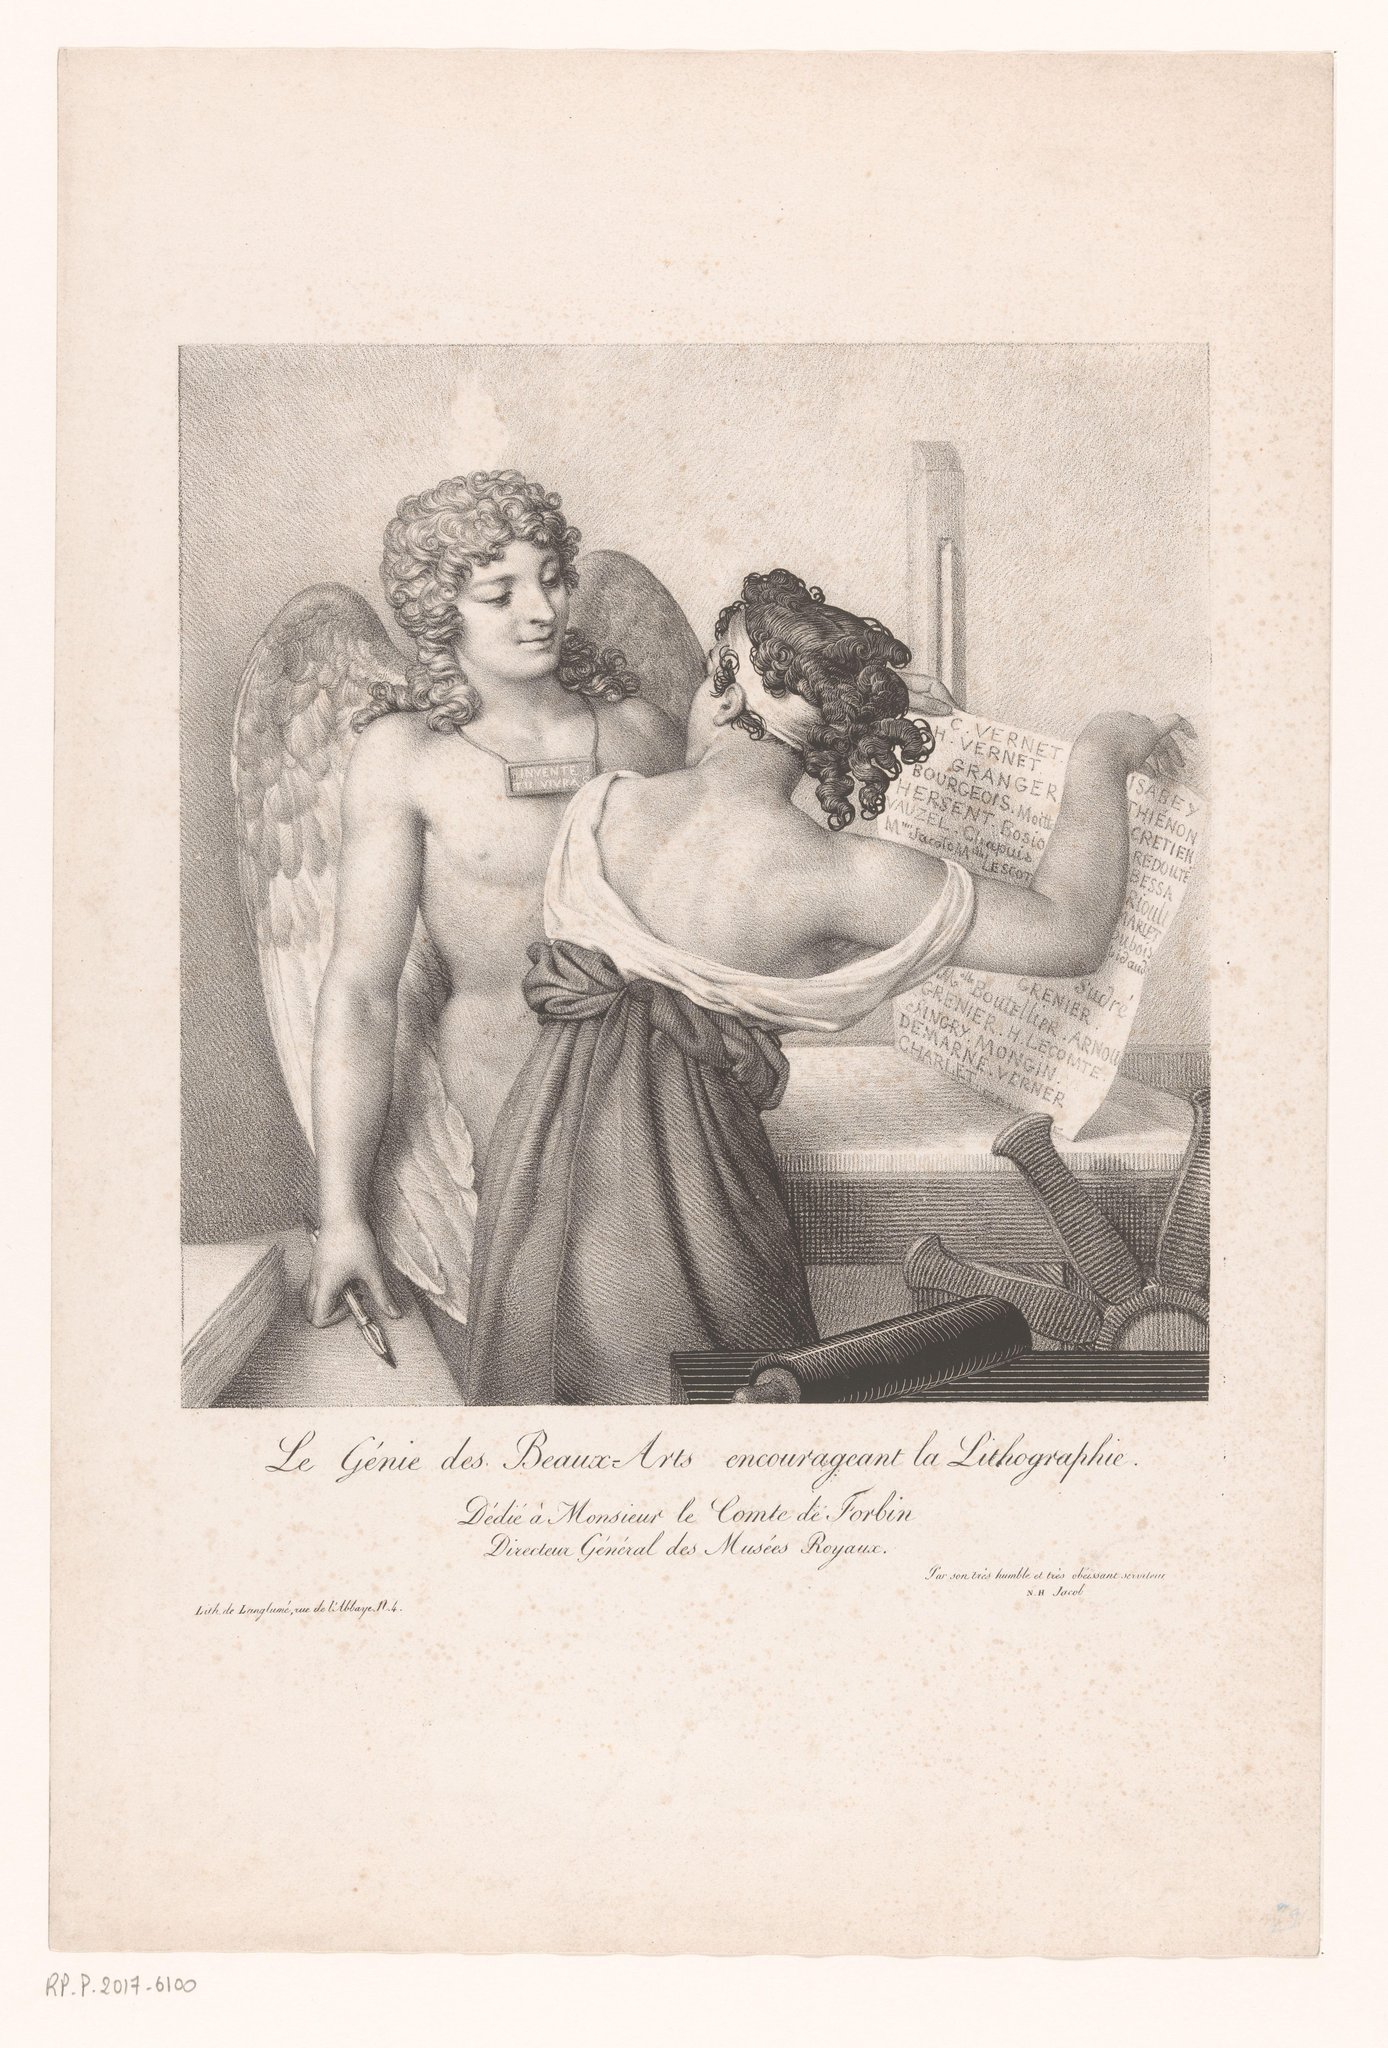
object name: print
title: Schone Kunsten en de Lithografie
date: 1819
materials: paper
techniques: lithograph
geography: paris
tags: print, e.g.: engraving, etching, lithograph, symbolic representations, allegories and emblems ~ art; 'arte' (ripa) (+ the work of art and its production)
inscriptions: collector's mark: Lugt 2228, collector's mark: Lugt 2760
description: De Genius van de Schone Kunsten moedigt de Personificatie van de Lithografie aan in haar werk.